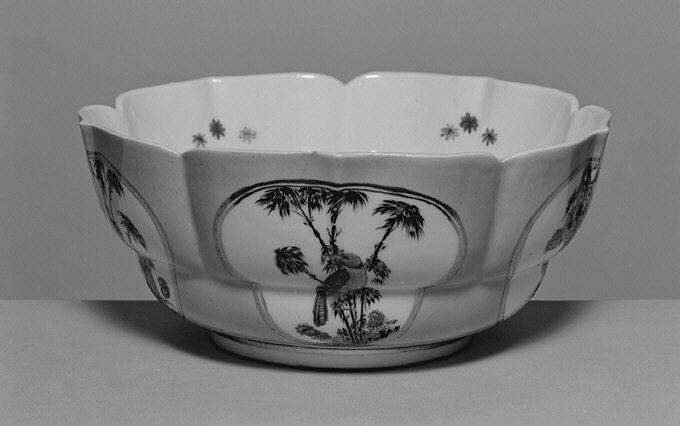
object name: bowl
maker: meissen manufactory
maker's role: manufactory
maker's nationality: german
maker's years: 1710-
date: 1735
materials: hard paste porcelain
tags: birds,trees